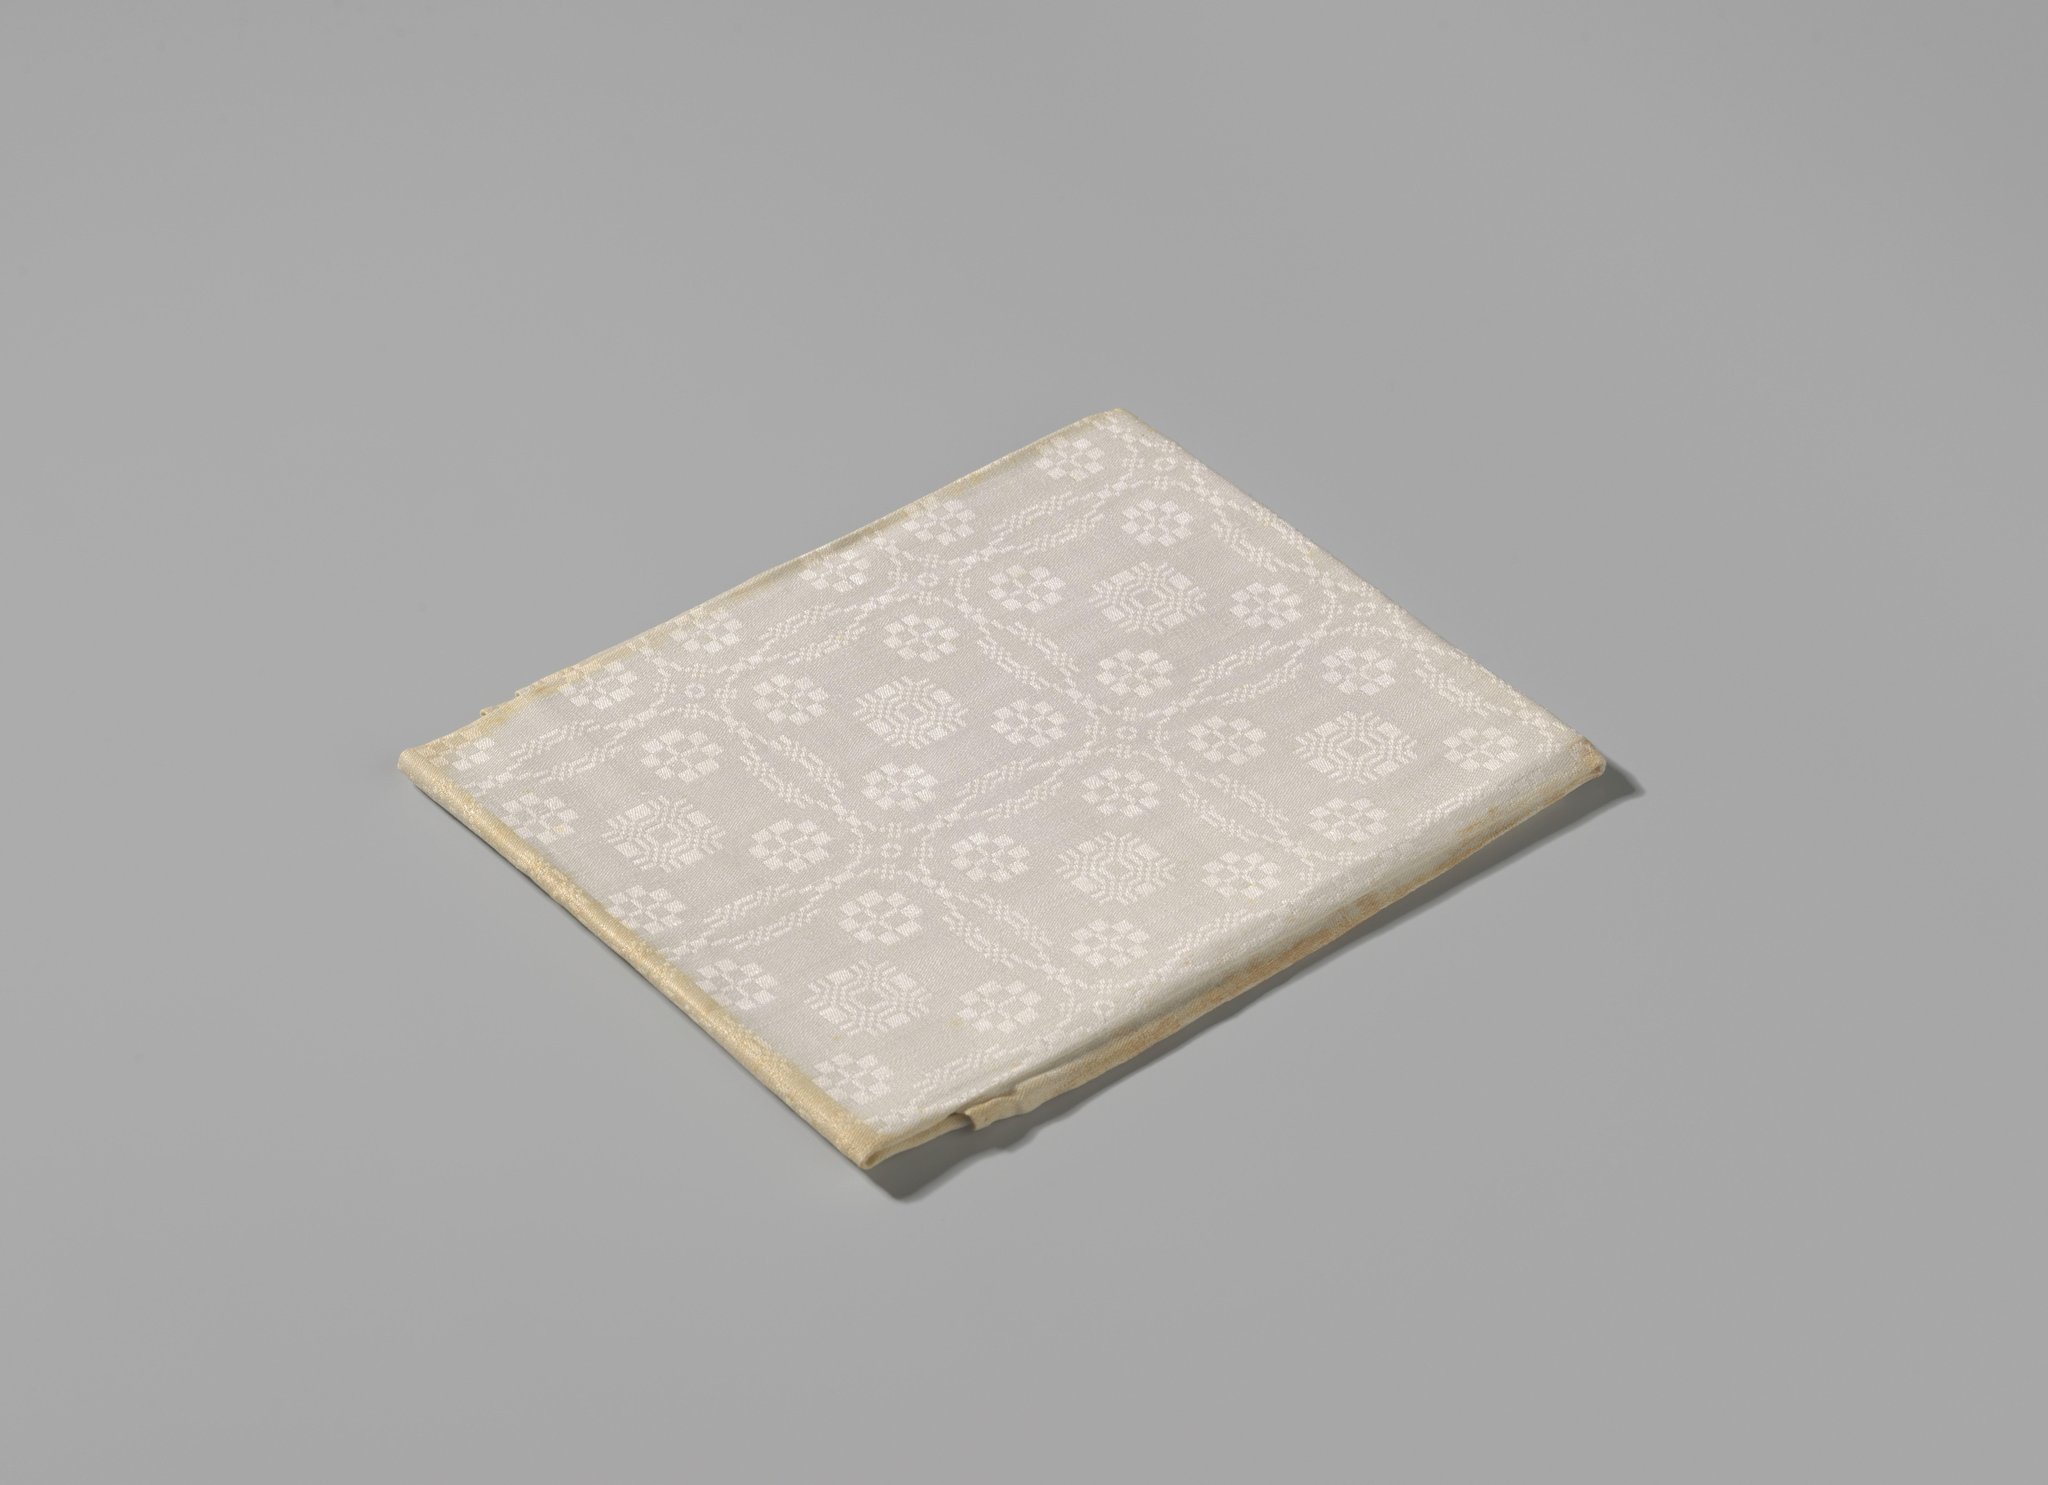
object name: napkin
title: Servet van pellendamast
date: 1700-1750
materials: linen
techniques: weave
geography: netherlands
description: Servet van pellendamast. Het servet is gemerkt: AOH. Bij het servet hoort een servet met invnr. BK-1980-114-B.